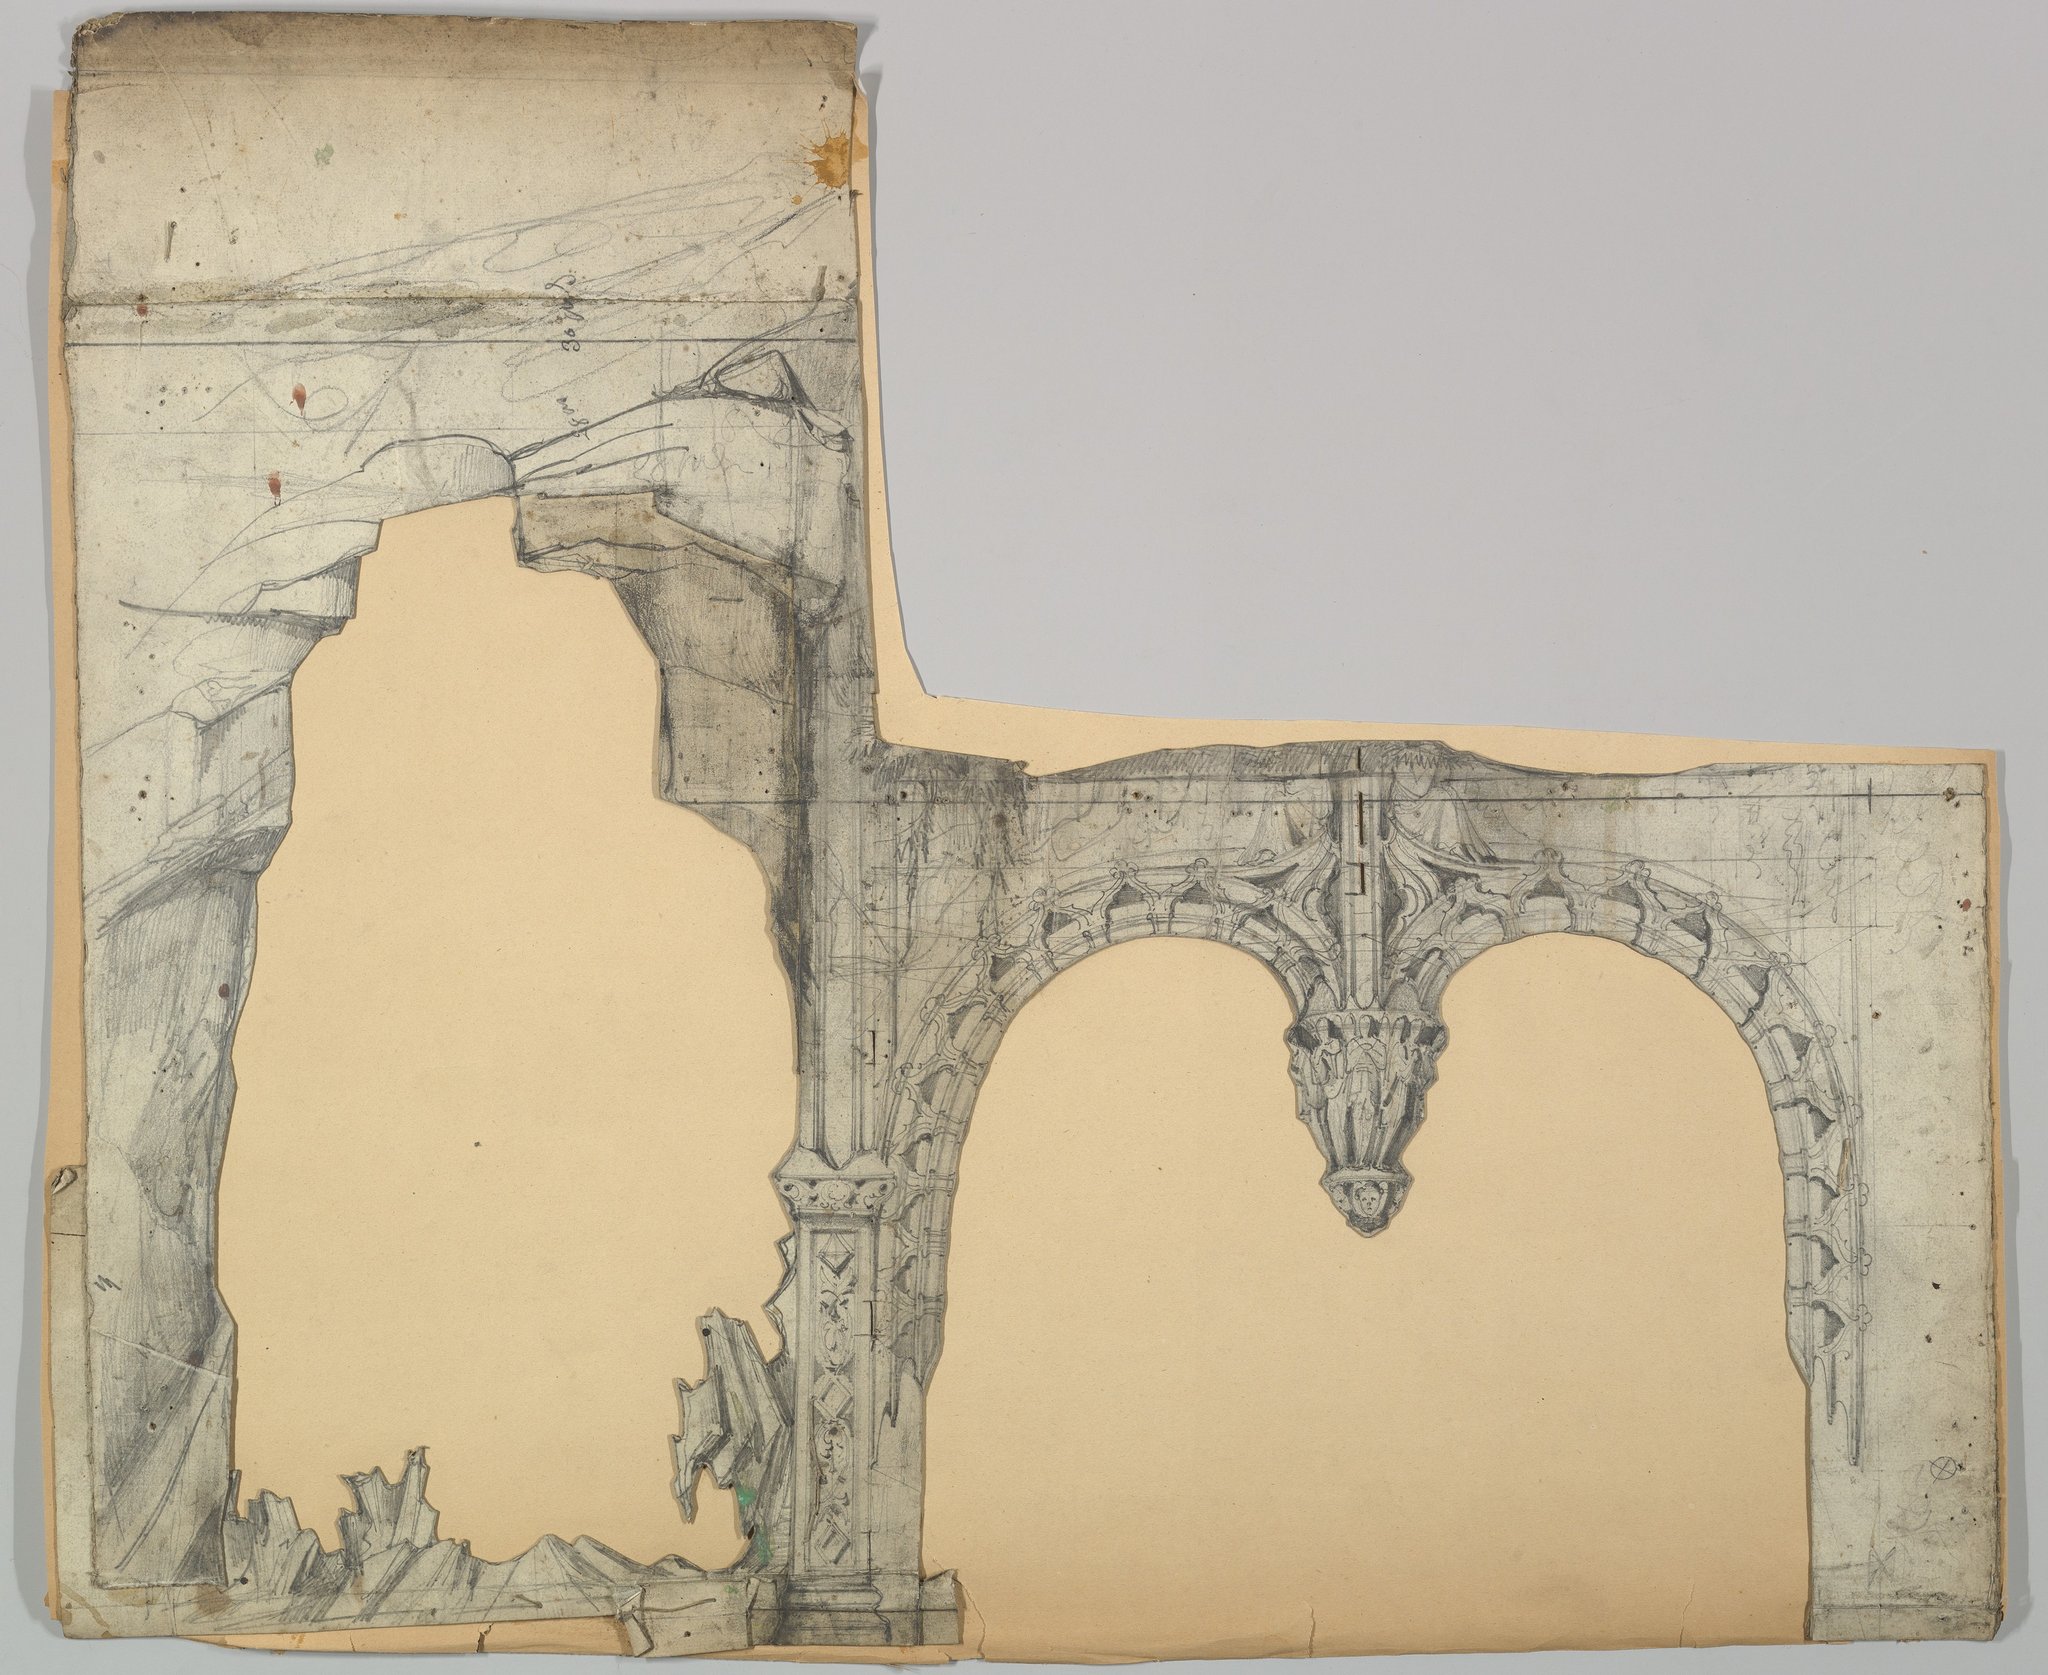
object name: drawing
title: Design for a Stage Set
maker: eugène cicéri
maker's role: artist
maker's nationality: french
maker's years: 1813-1890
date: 1830-1890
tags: stage design